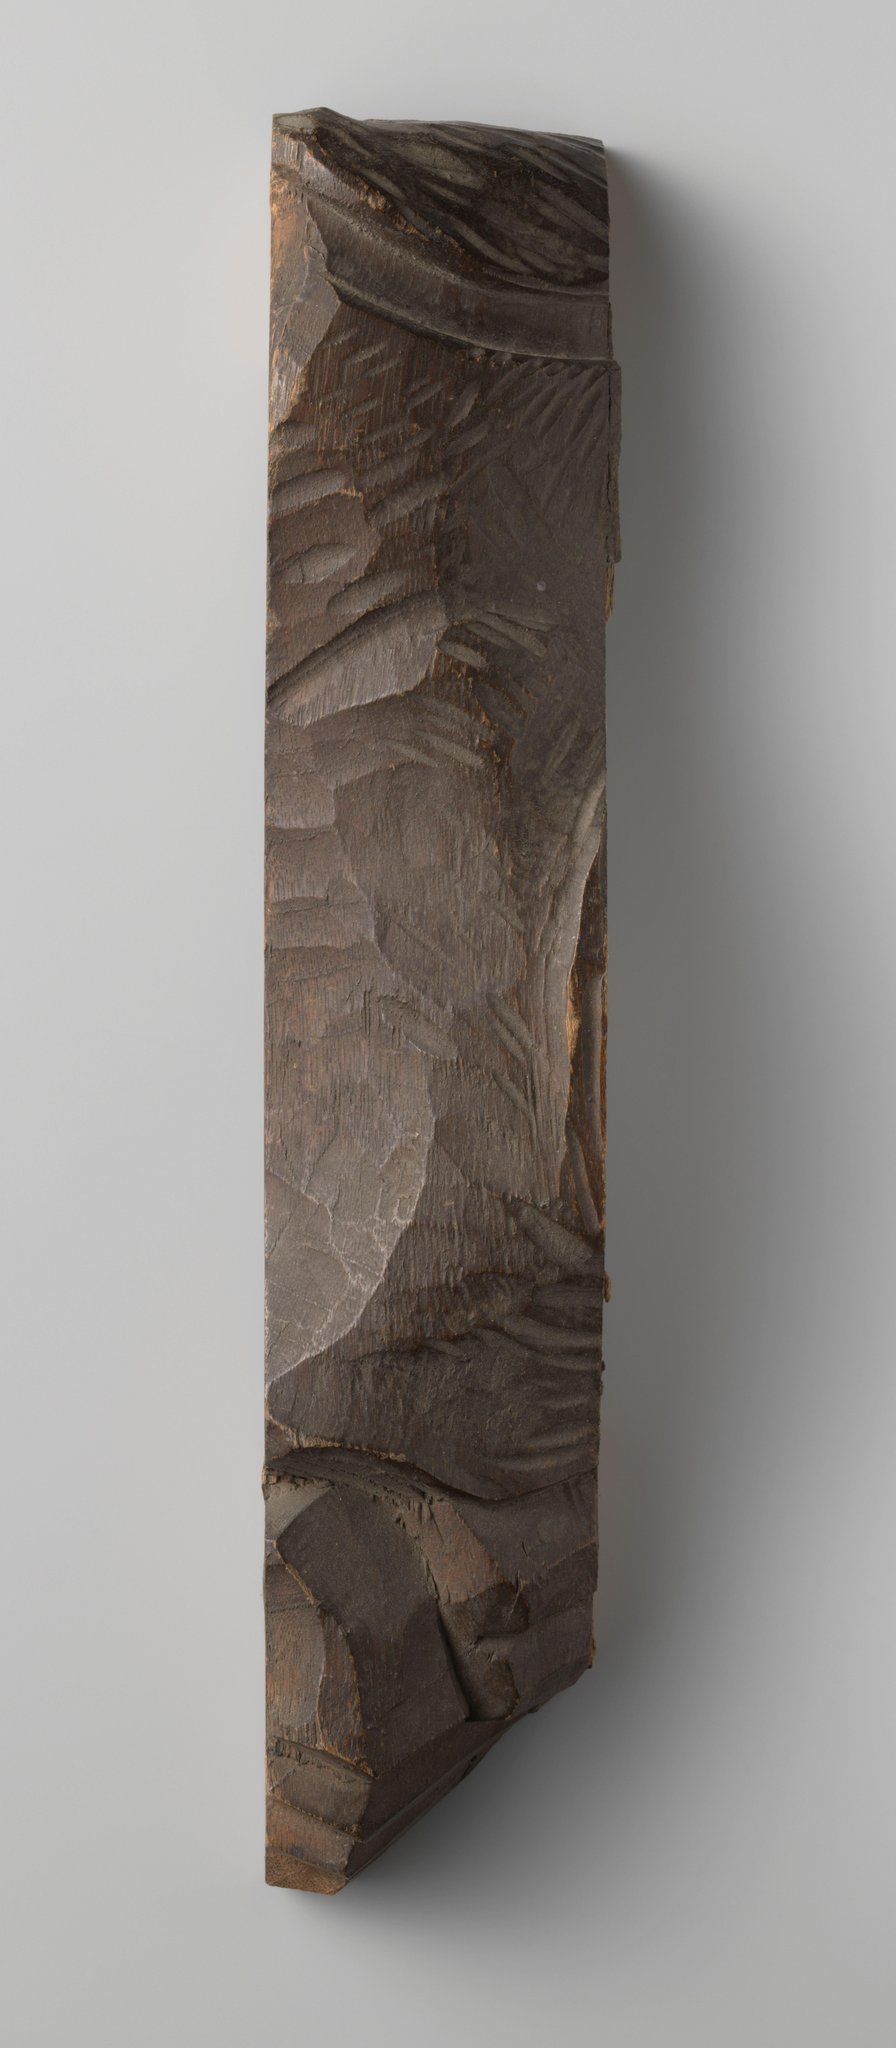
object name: fragment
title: The Meeting of the Magi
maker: Anonymous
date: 1800-1900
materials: wood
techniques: cutting, polychromy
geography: netherlands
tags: the three wise men meet at the crossroads, den bosch